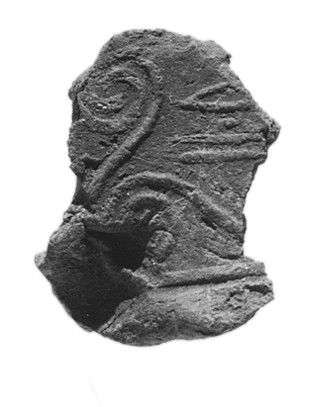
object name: sealing, administrative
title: Administrative Seal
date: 1981-1640 BCE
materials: clay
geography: egypt